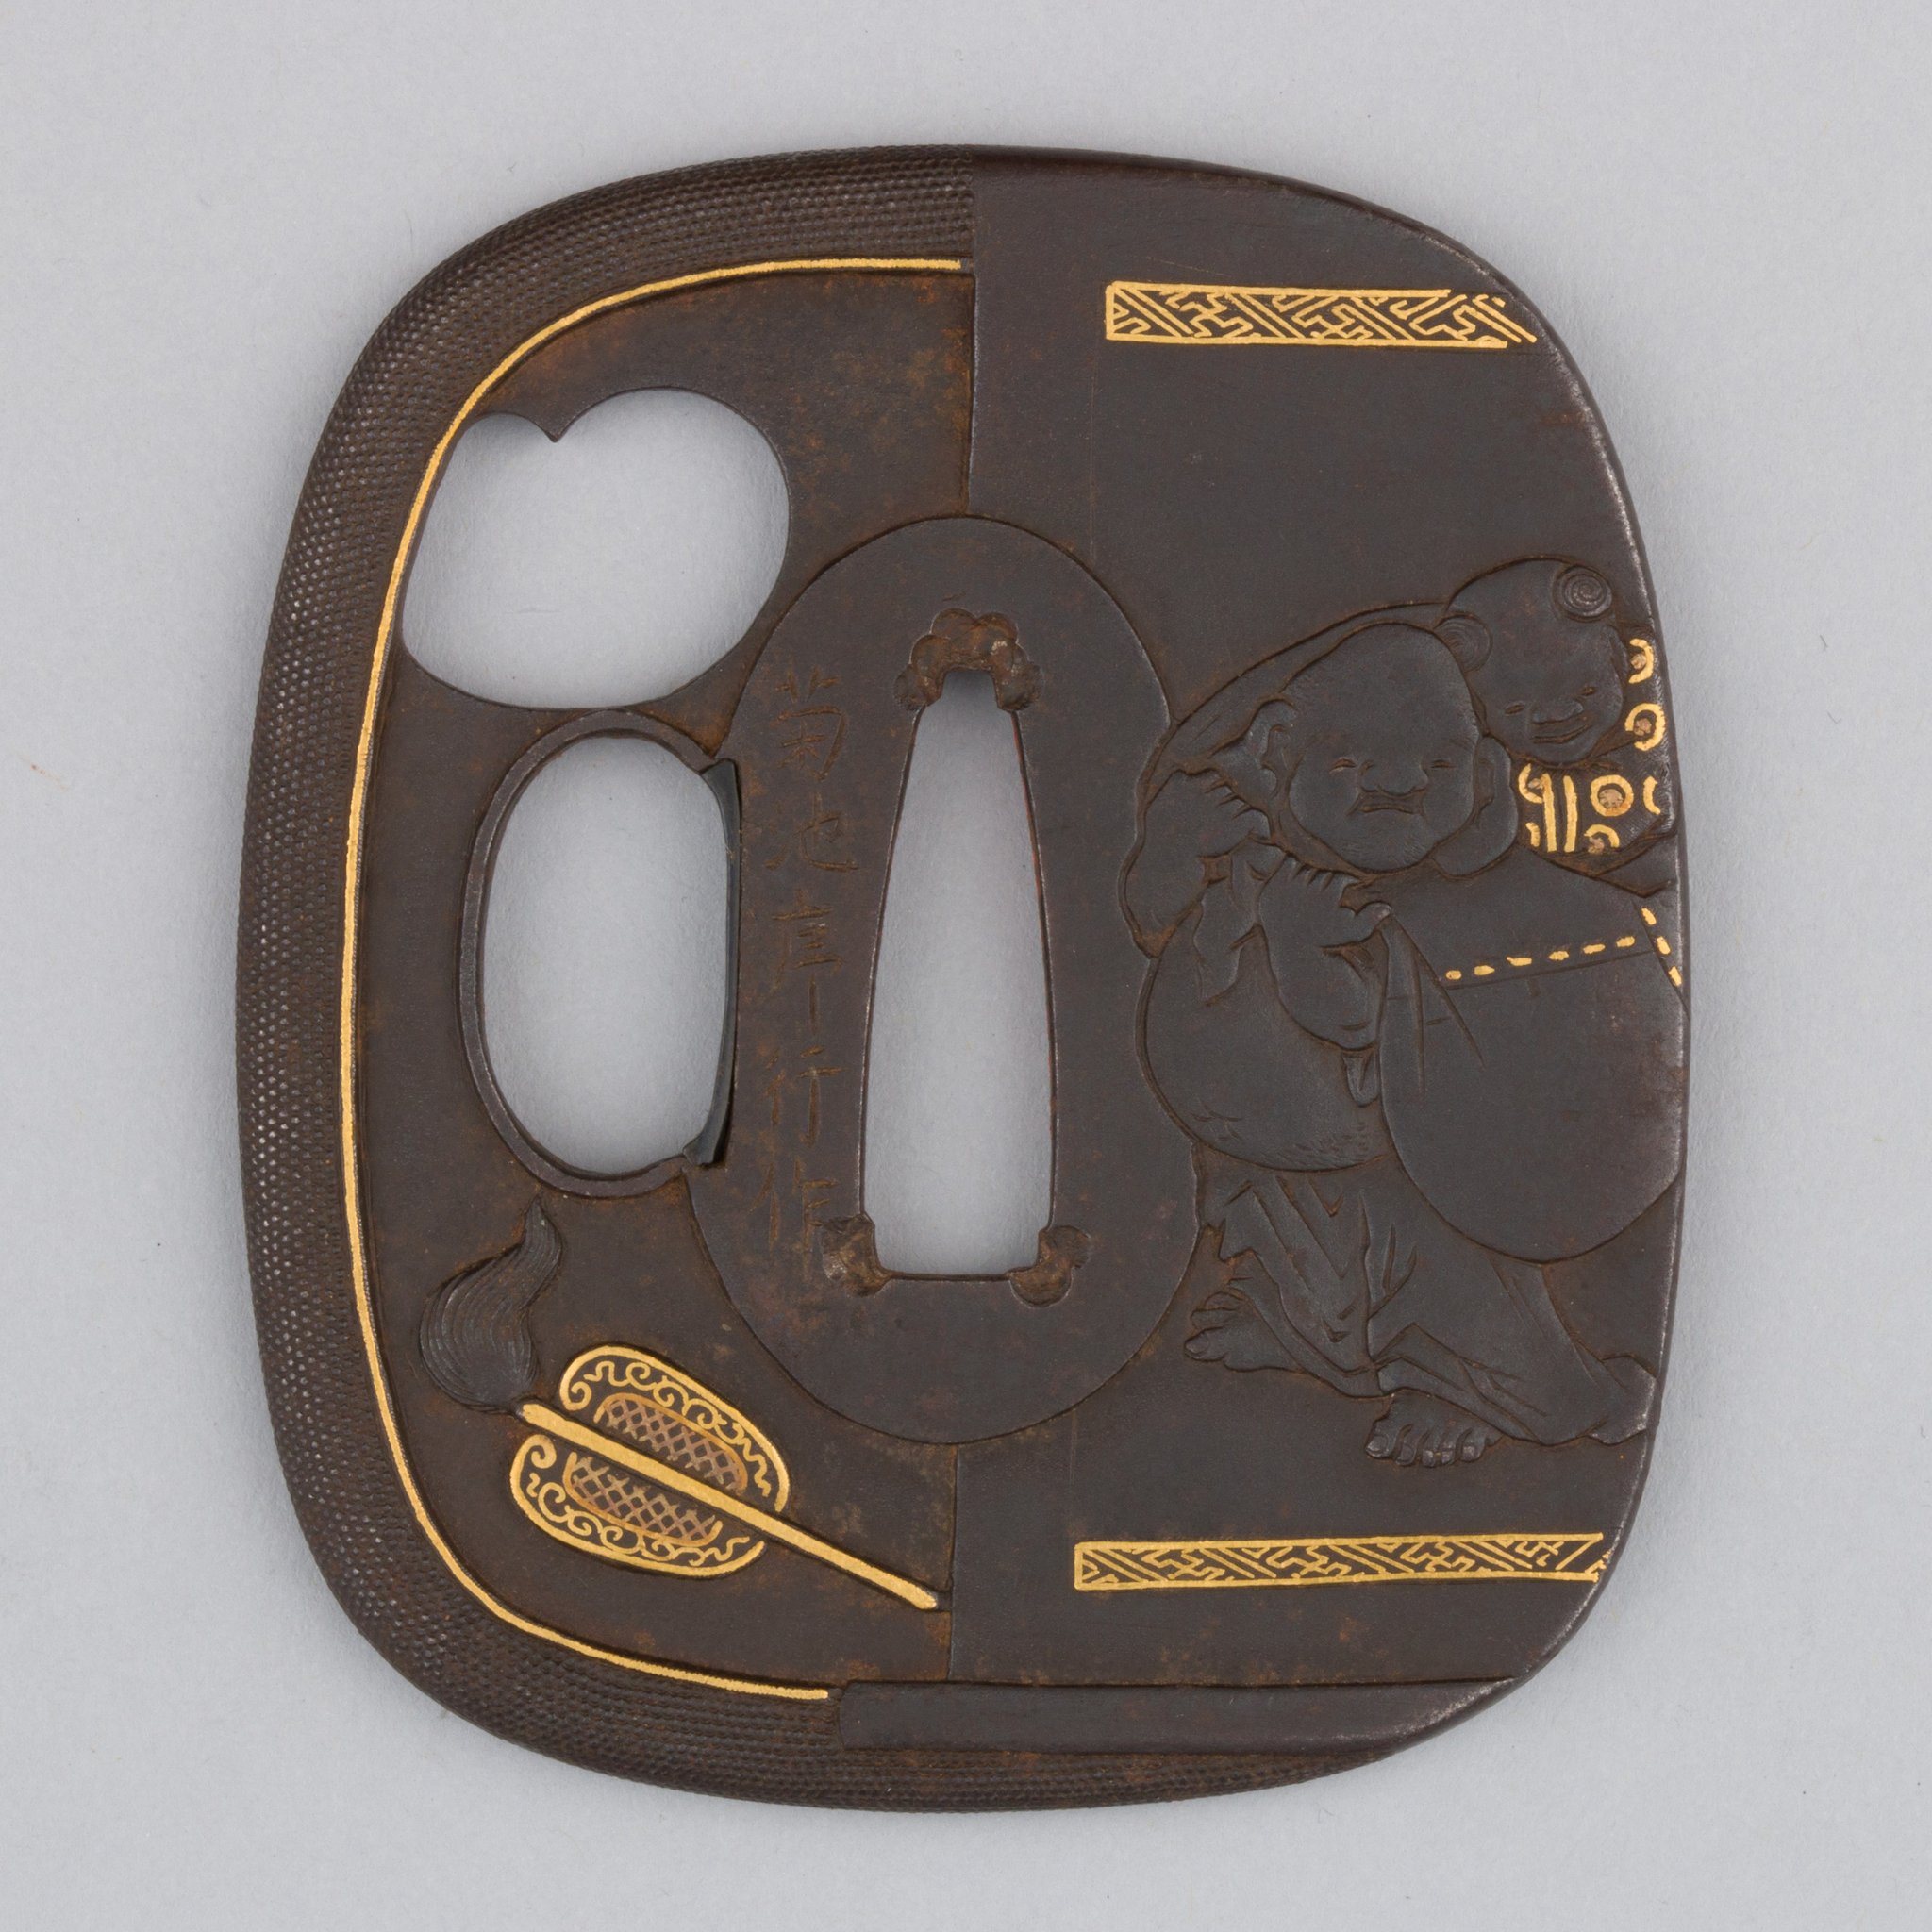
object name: sword guard tsuba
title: Sword Guard (Tsuba)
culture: japanese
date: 1615-1868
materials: copper, gold, iron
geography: japan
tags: men